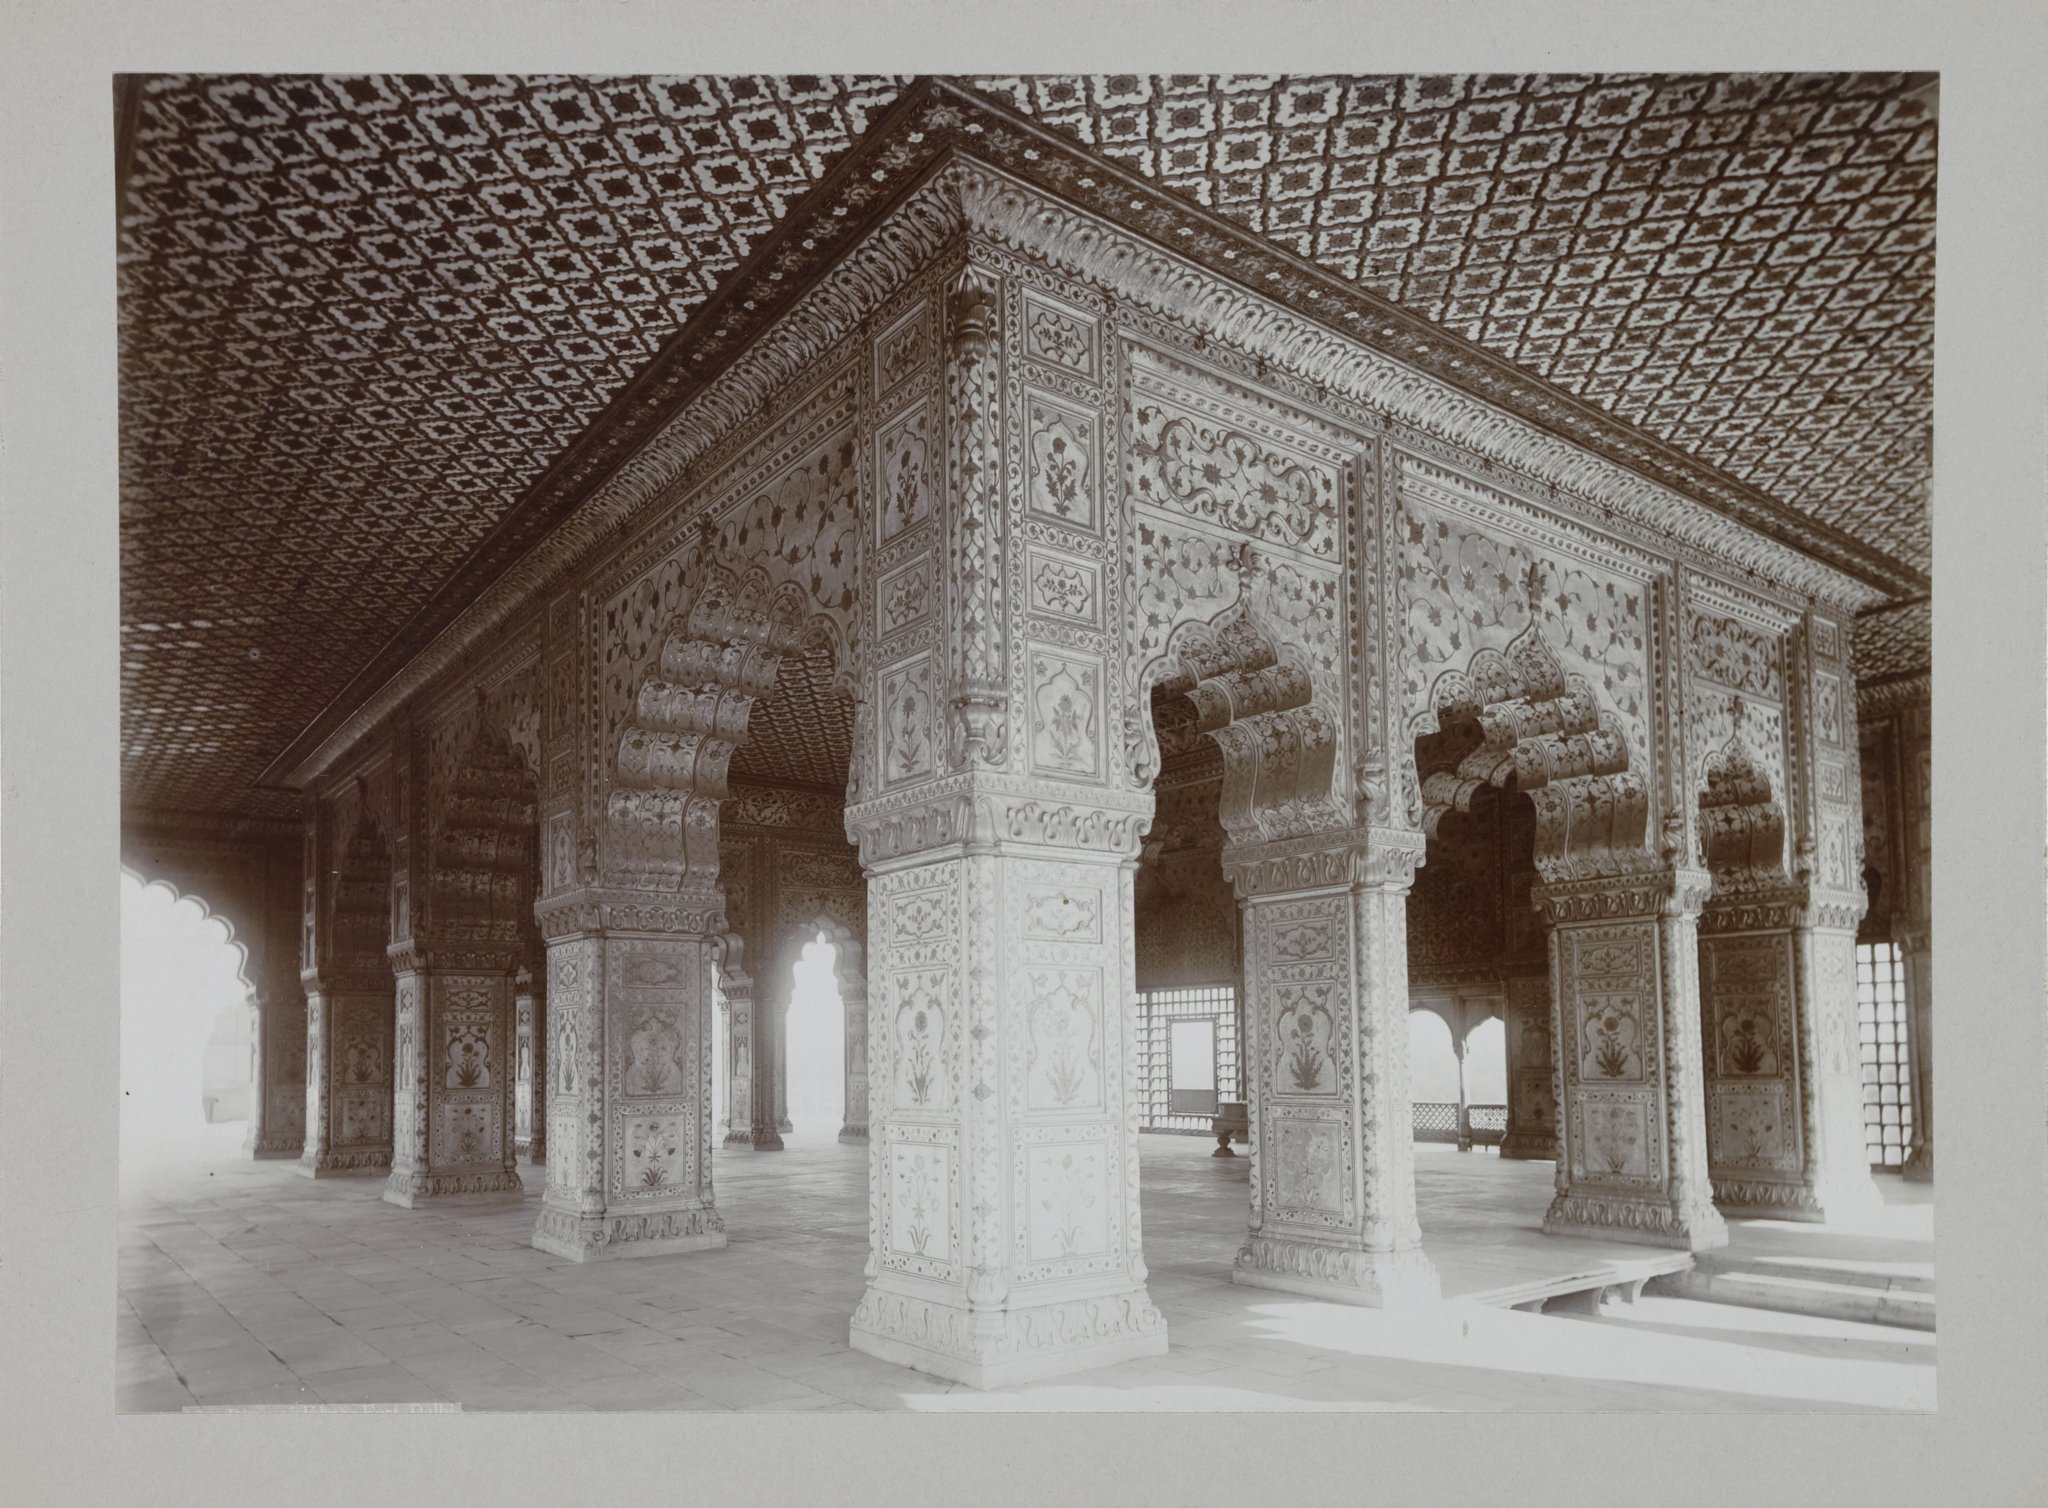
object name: photograph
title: Interior of the Diwan-i-Khas in the Red Fort at Delhi, India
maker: Anonymous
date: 1895-1915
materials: cardboard, paper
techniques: gelatin silver print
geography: delhi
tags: delhi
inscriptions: title: ‘Diwan-i-Khas, Fort Delhi’, number: ‘25.’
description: De Zaal der Besloten Audiënties (Diwan -i-Khas) bevindt zich binnen het Rode Fort van Delhi.